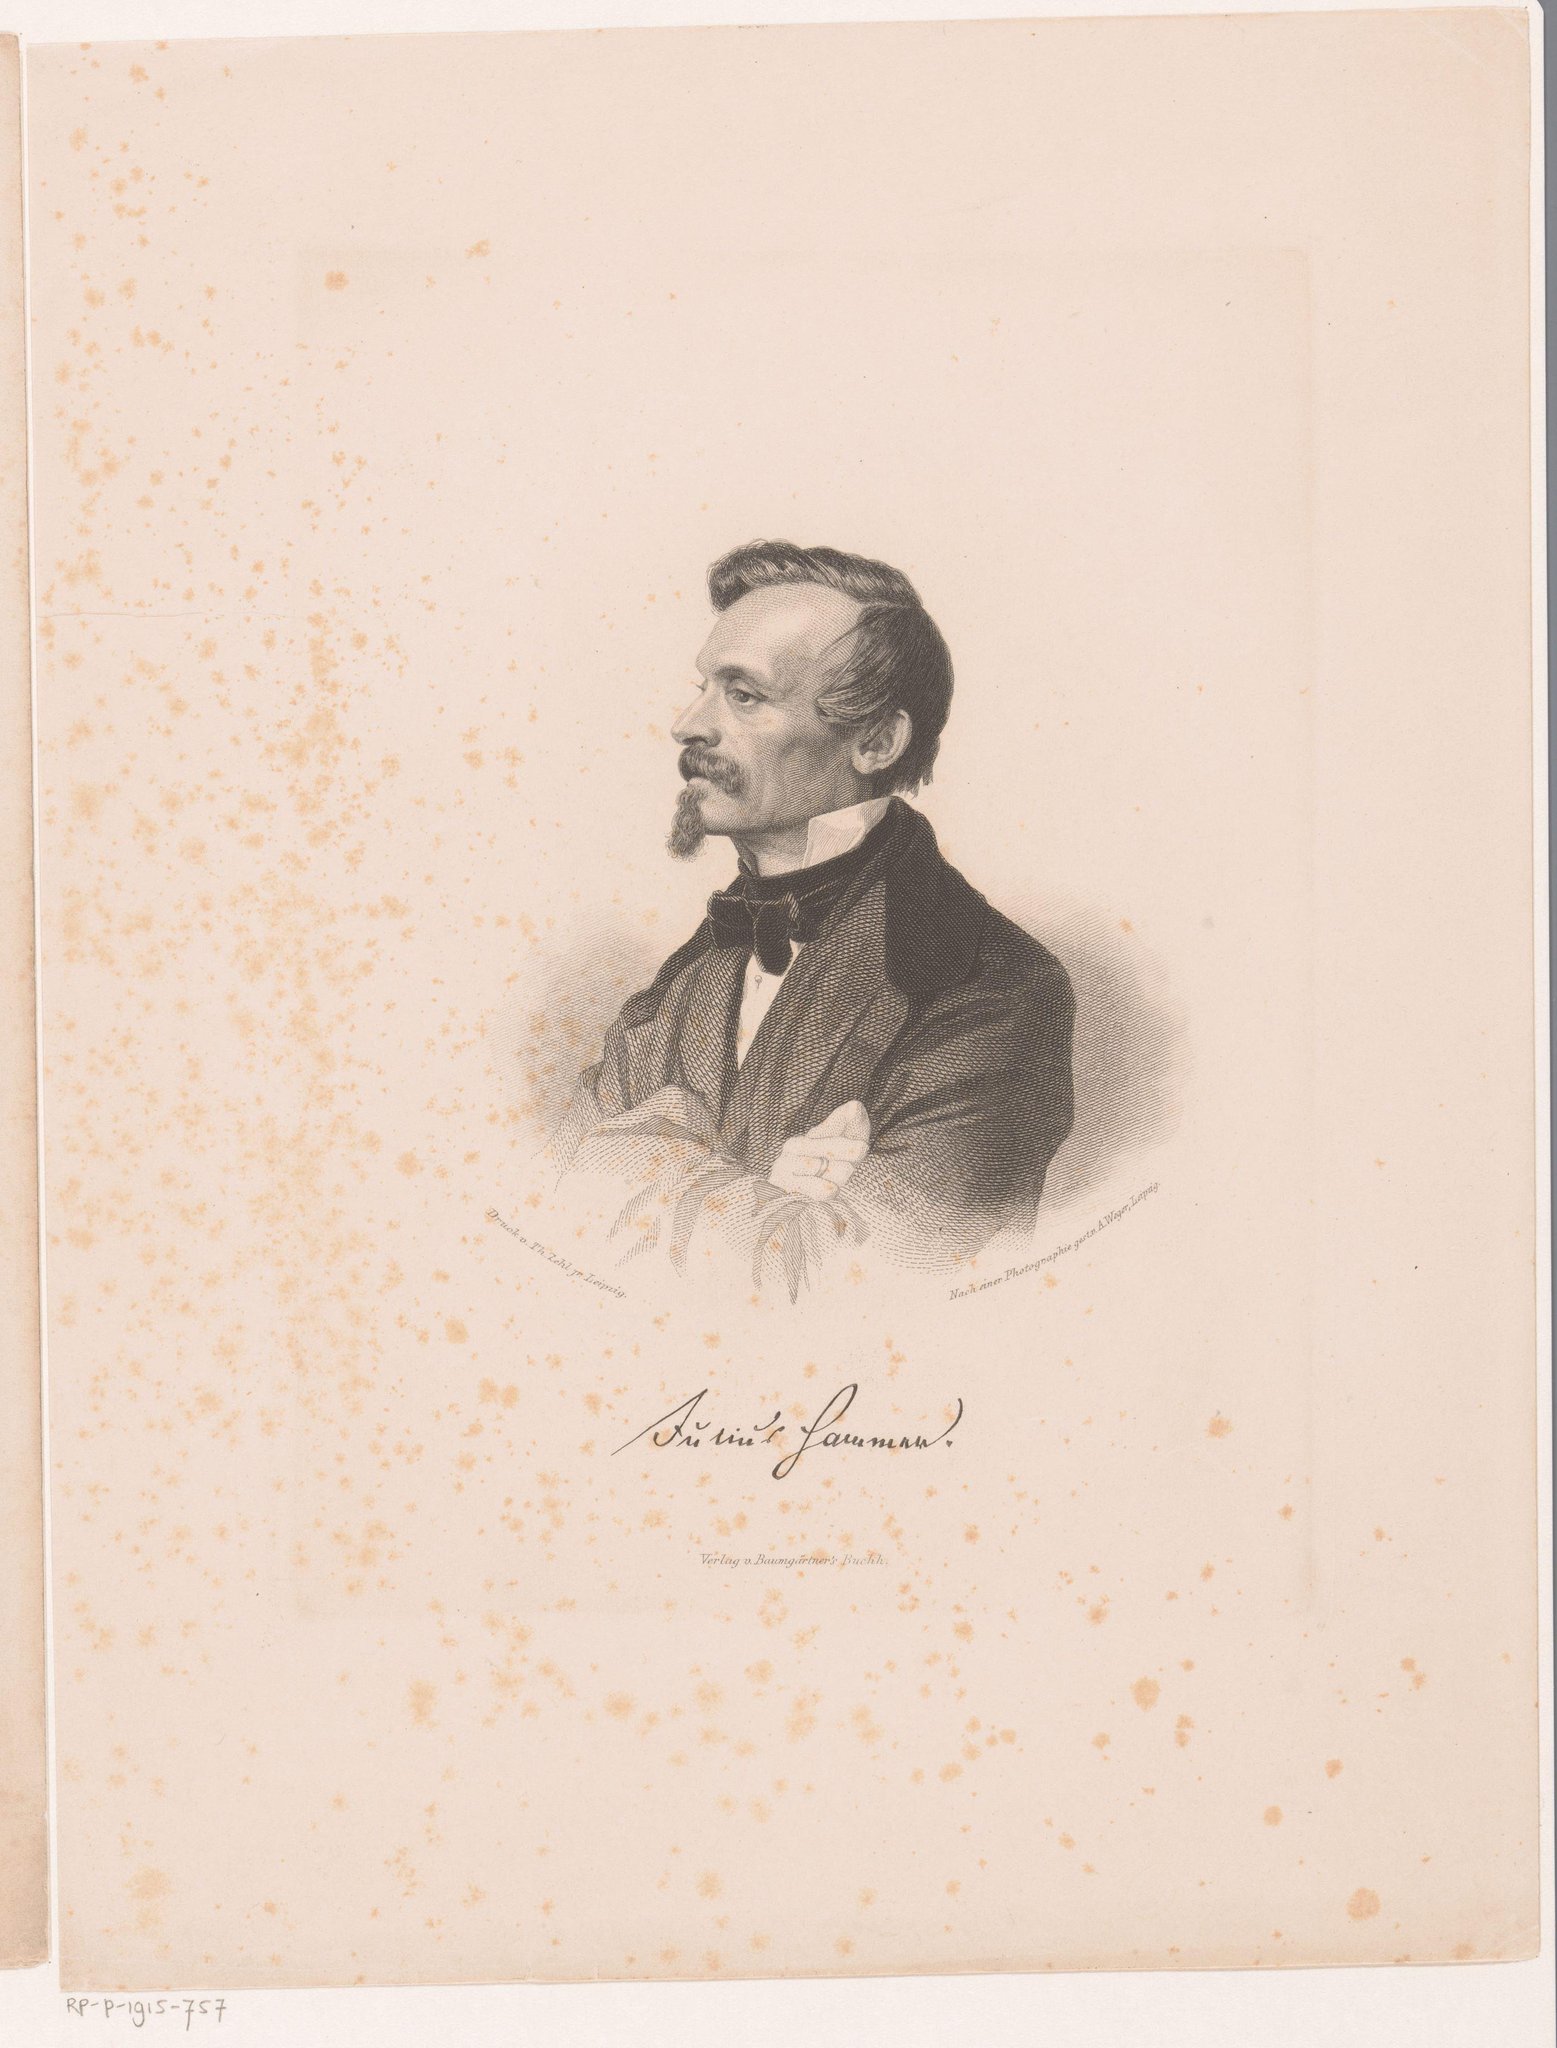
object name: print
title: Portret van Julius Hammer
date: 1849-1892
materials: paper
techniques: engraving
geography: leipzig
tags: historical persons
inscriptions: collector's mark: Lugt 2228